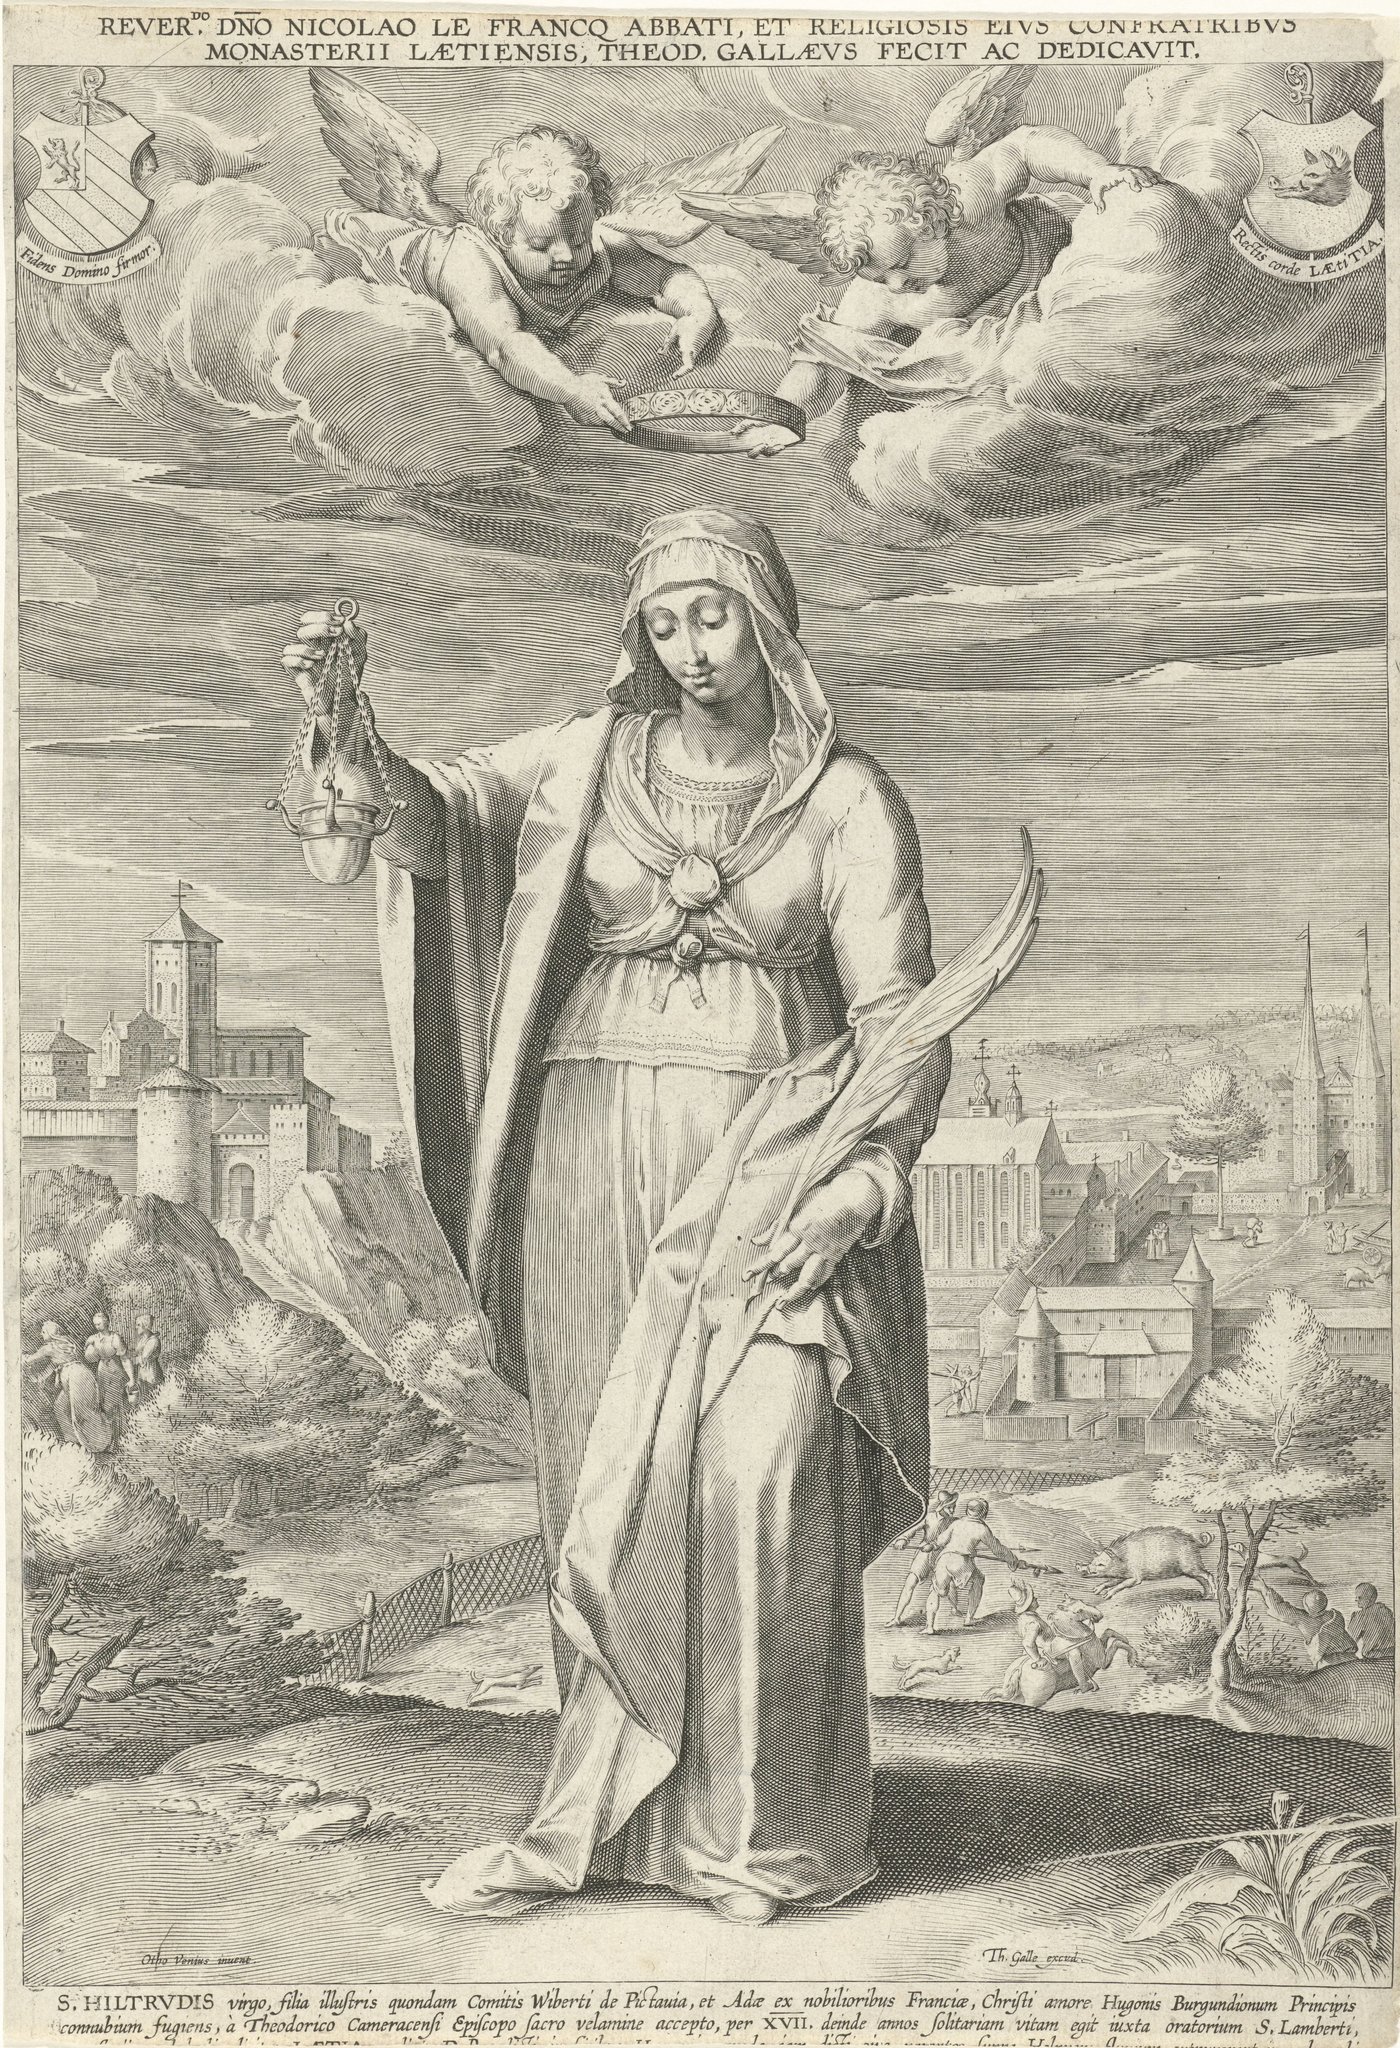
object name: print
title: Heilige Hiltrude van Liessies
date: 1581-1633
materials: paper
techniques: engraving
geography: antwerp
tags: boar-hunting, female saints (with name)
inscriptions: collector's mark: Lugt 2228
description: De heilige Hiltrude staande, met in de rechterhand een brandende olielamp. In de achtergrond een landschap met een kasteel en een klooster (Liessies), waar men jaagt op een zwijn. De prent heeft een Latijns onderschrift.